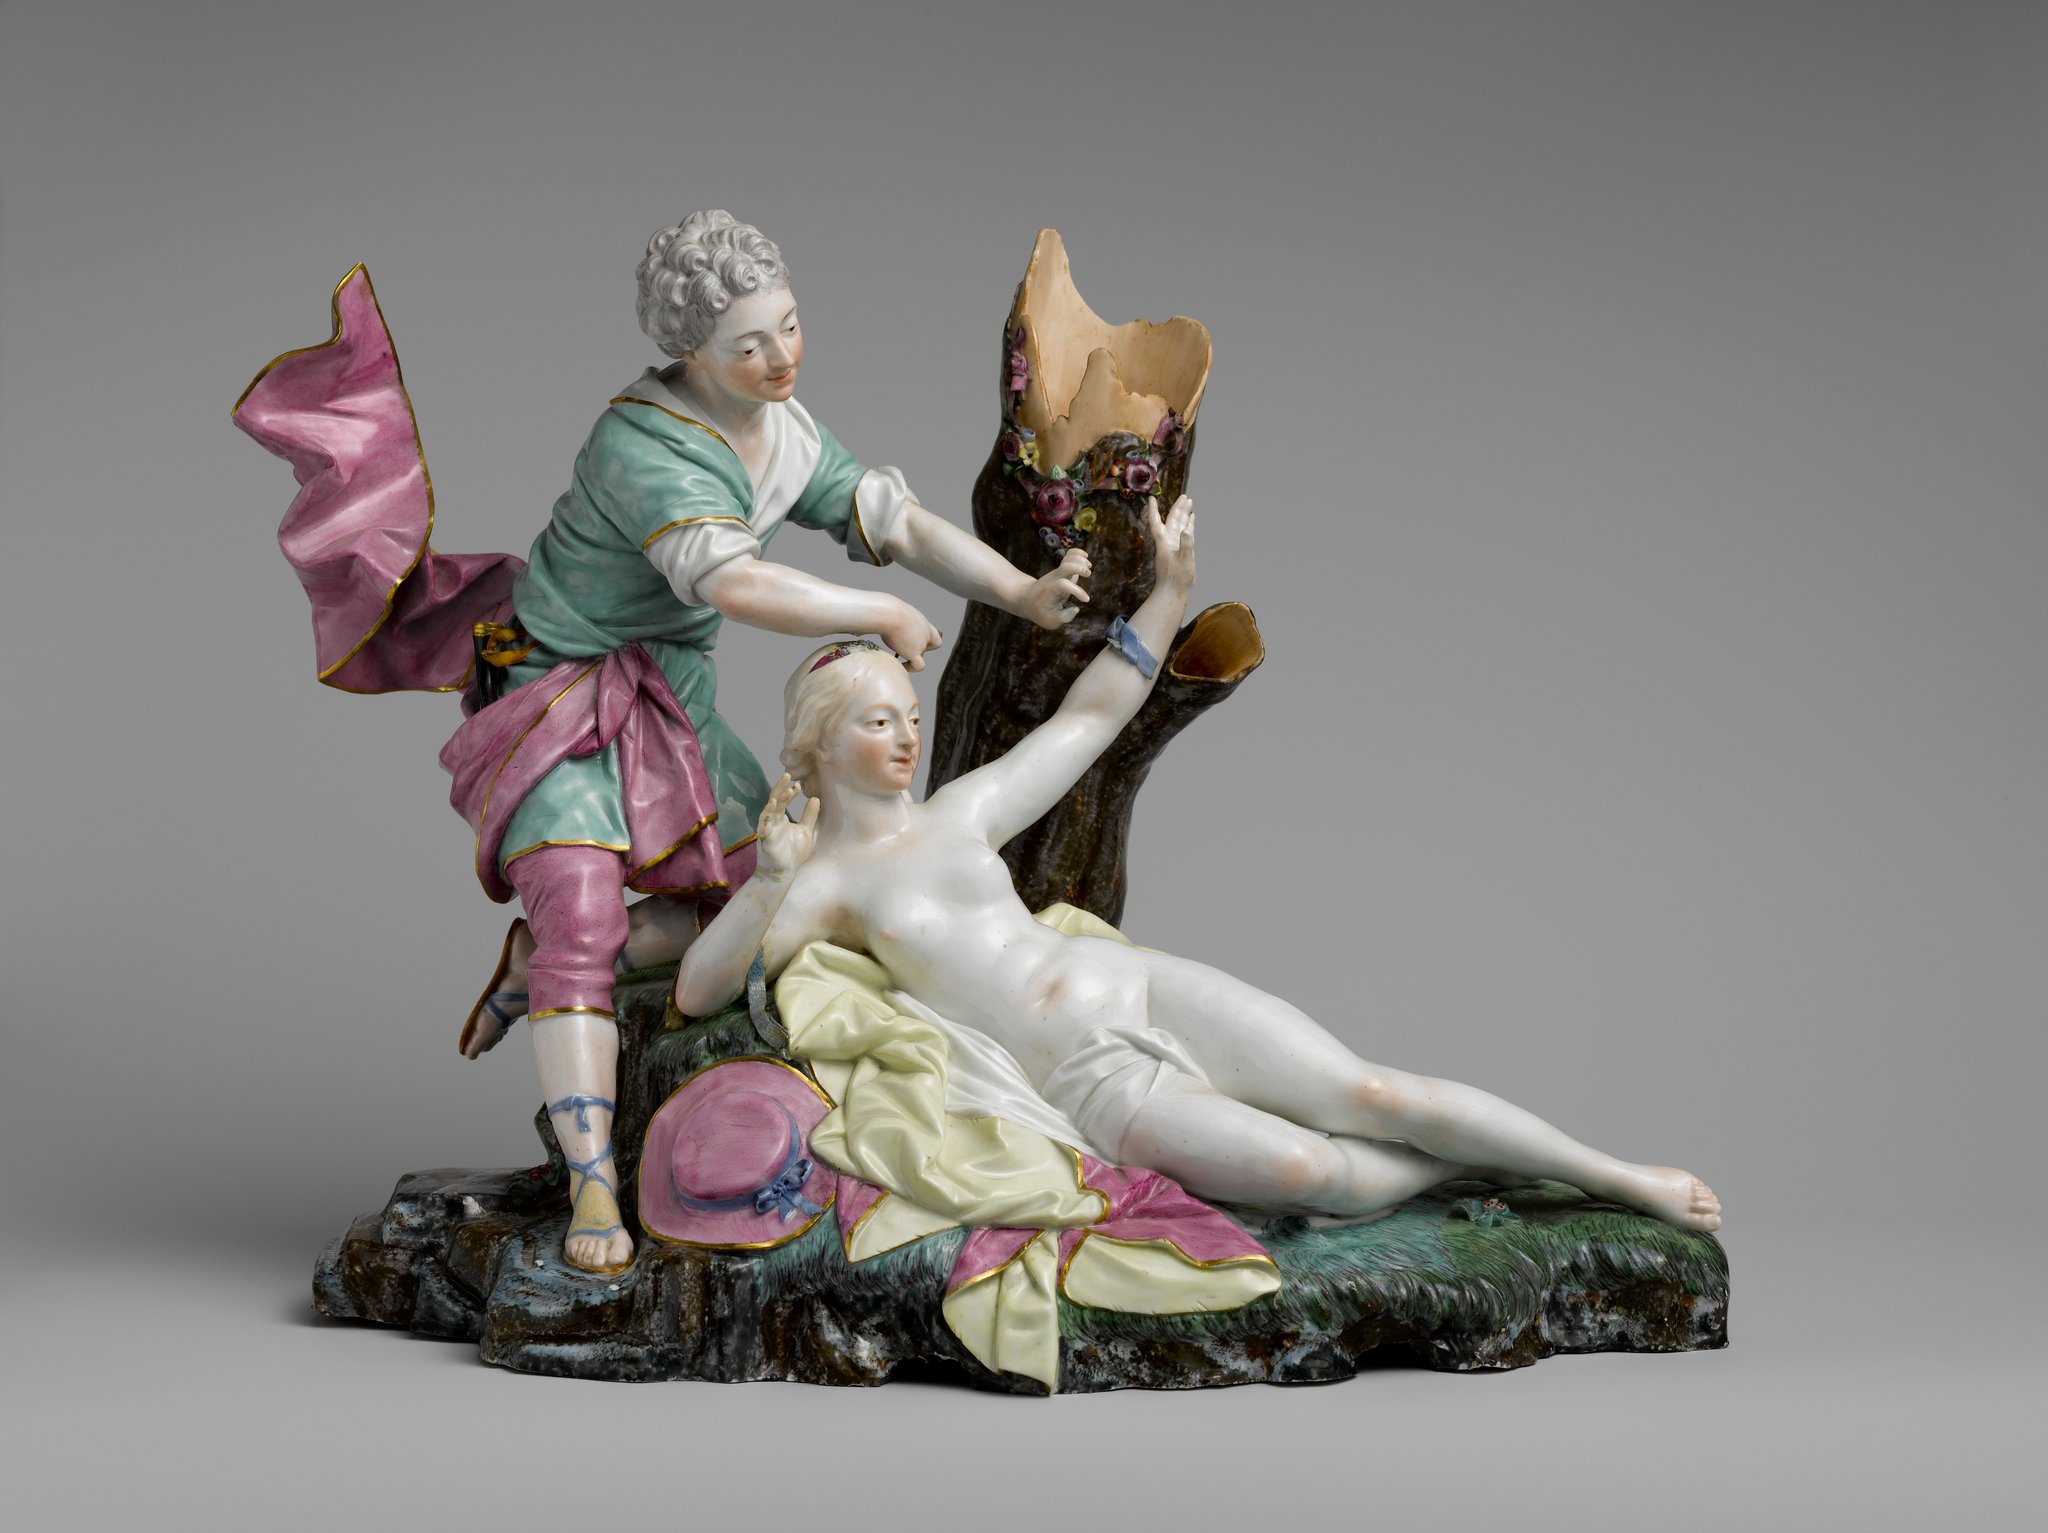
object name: group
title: Amintas Freeing Sylvia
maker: höchst manufactory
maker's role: manufactory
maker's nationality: german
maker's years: 1746-1796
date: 1770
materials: hard paste porcelain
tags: women,female nudes